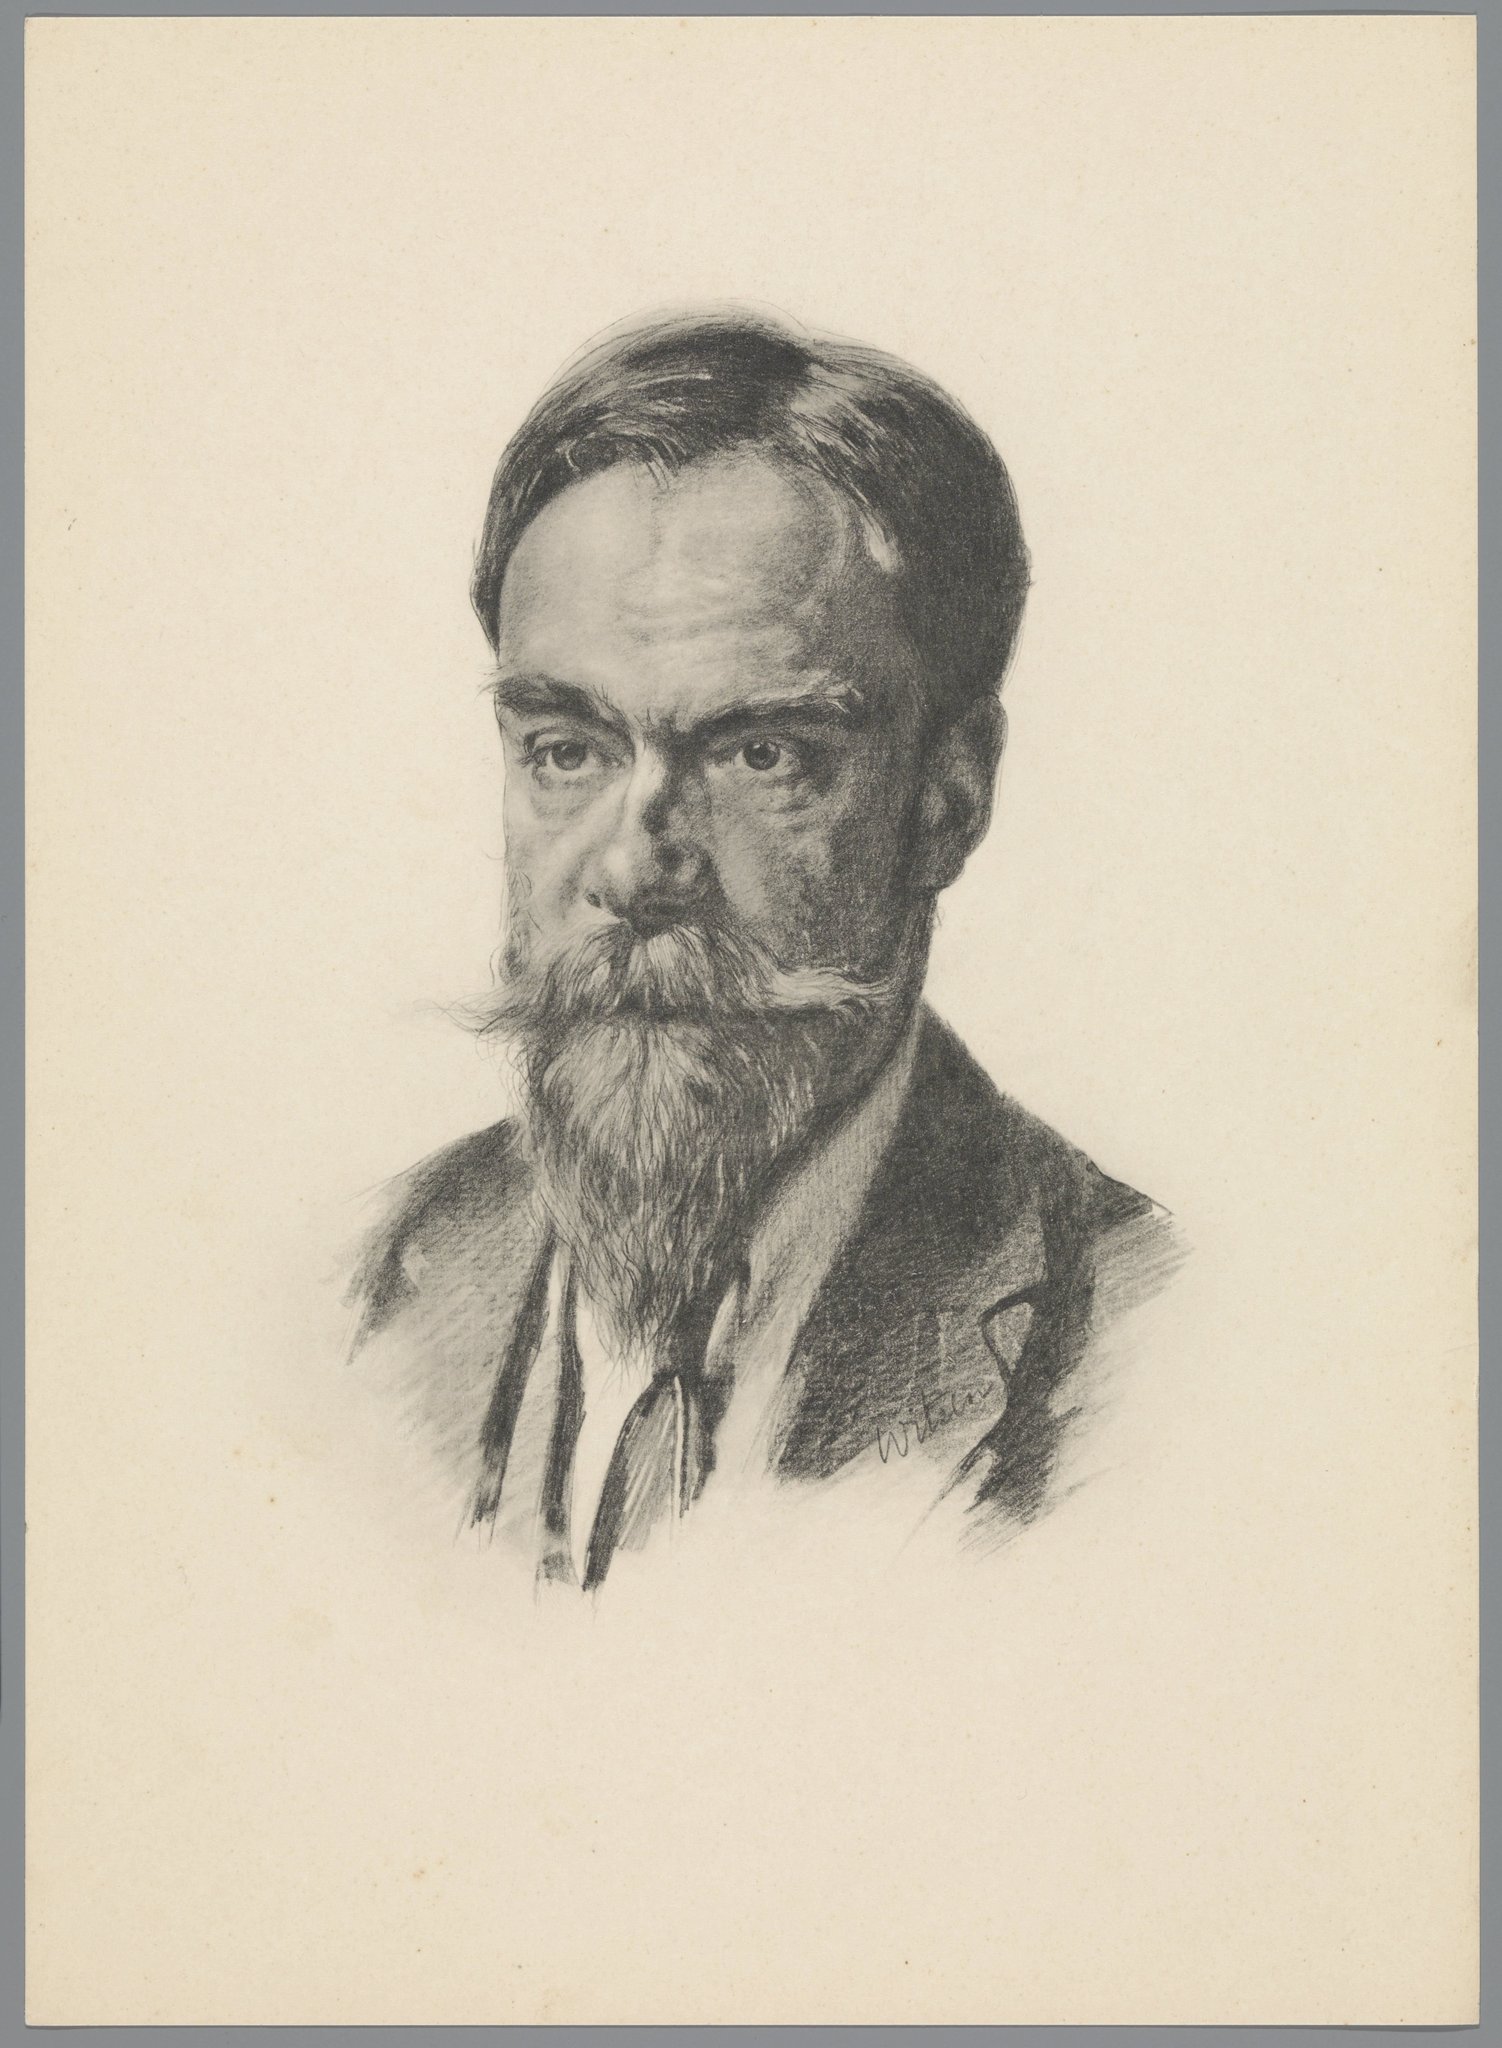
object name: print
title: Reproductie naar krijttekening met portret van Frans Coenen Jr.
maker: Anonymous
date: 1860-1915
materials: paper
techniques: photograph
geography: netherlands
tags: amsterdam, frans coenen (1866-1936)